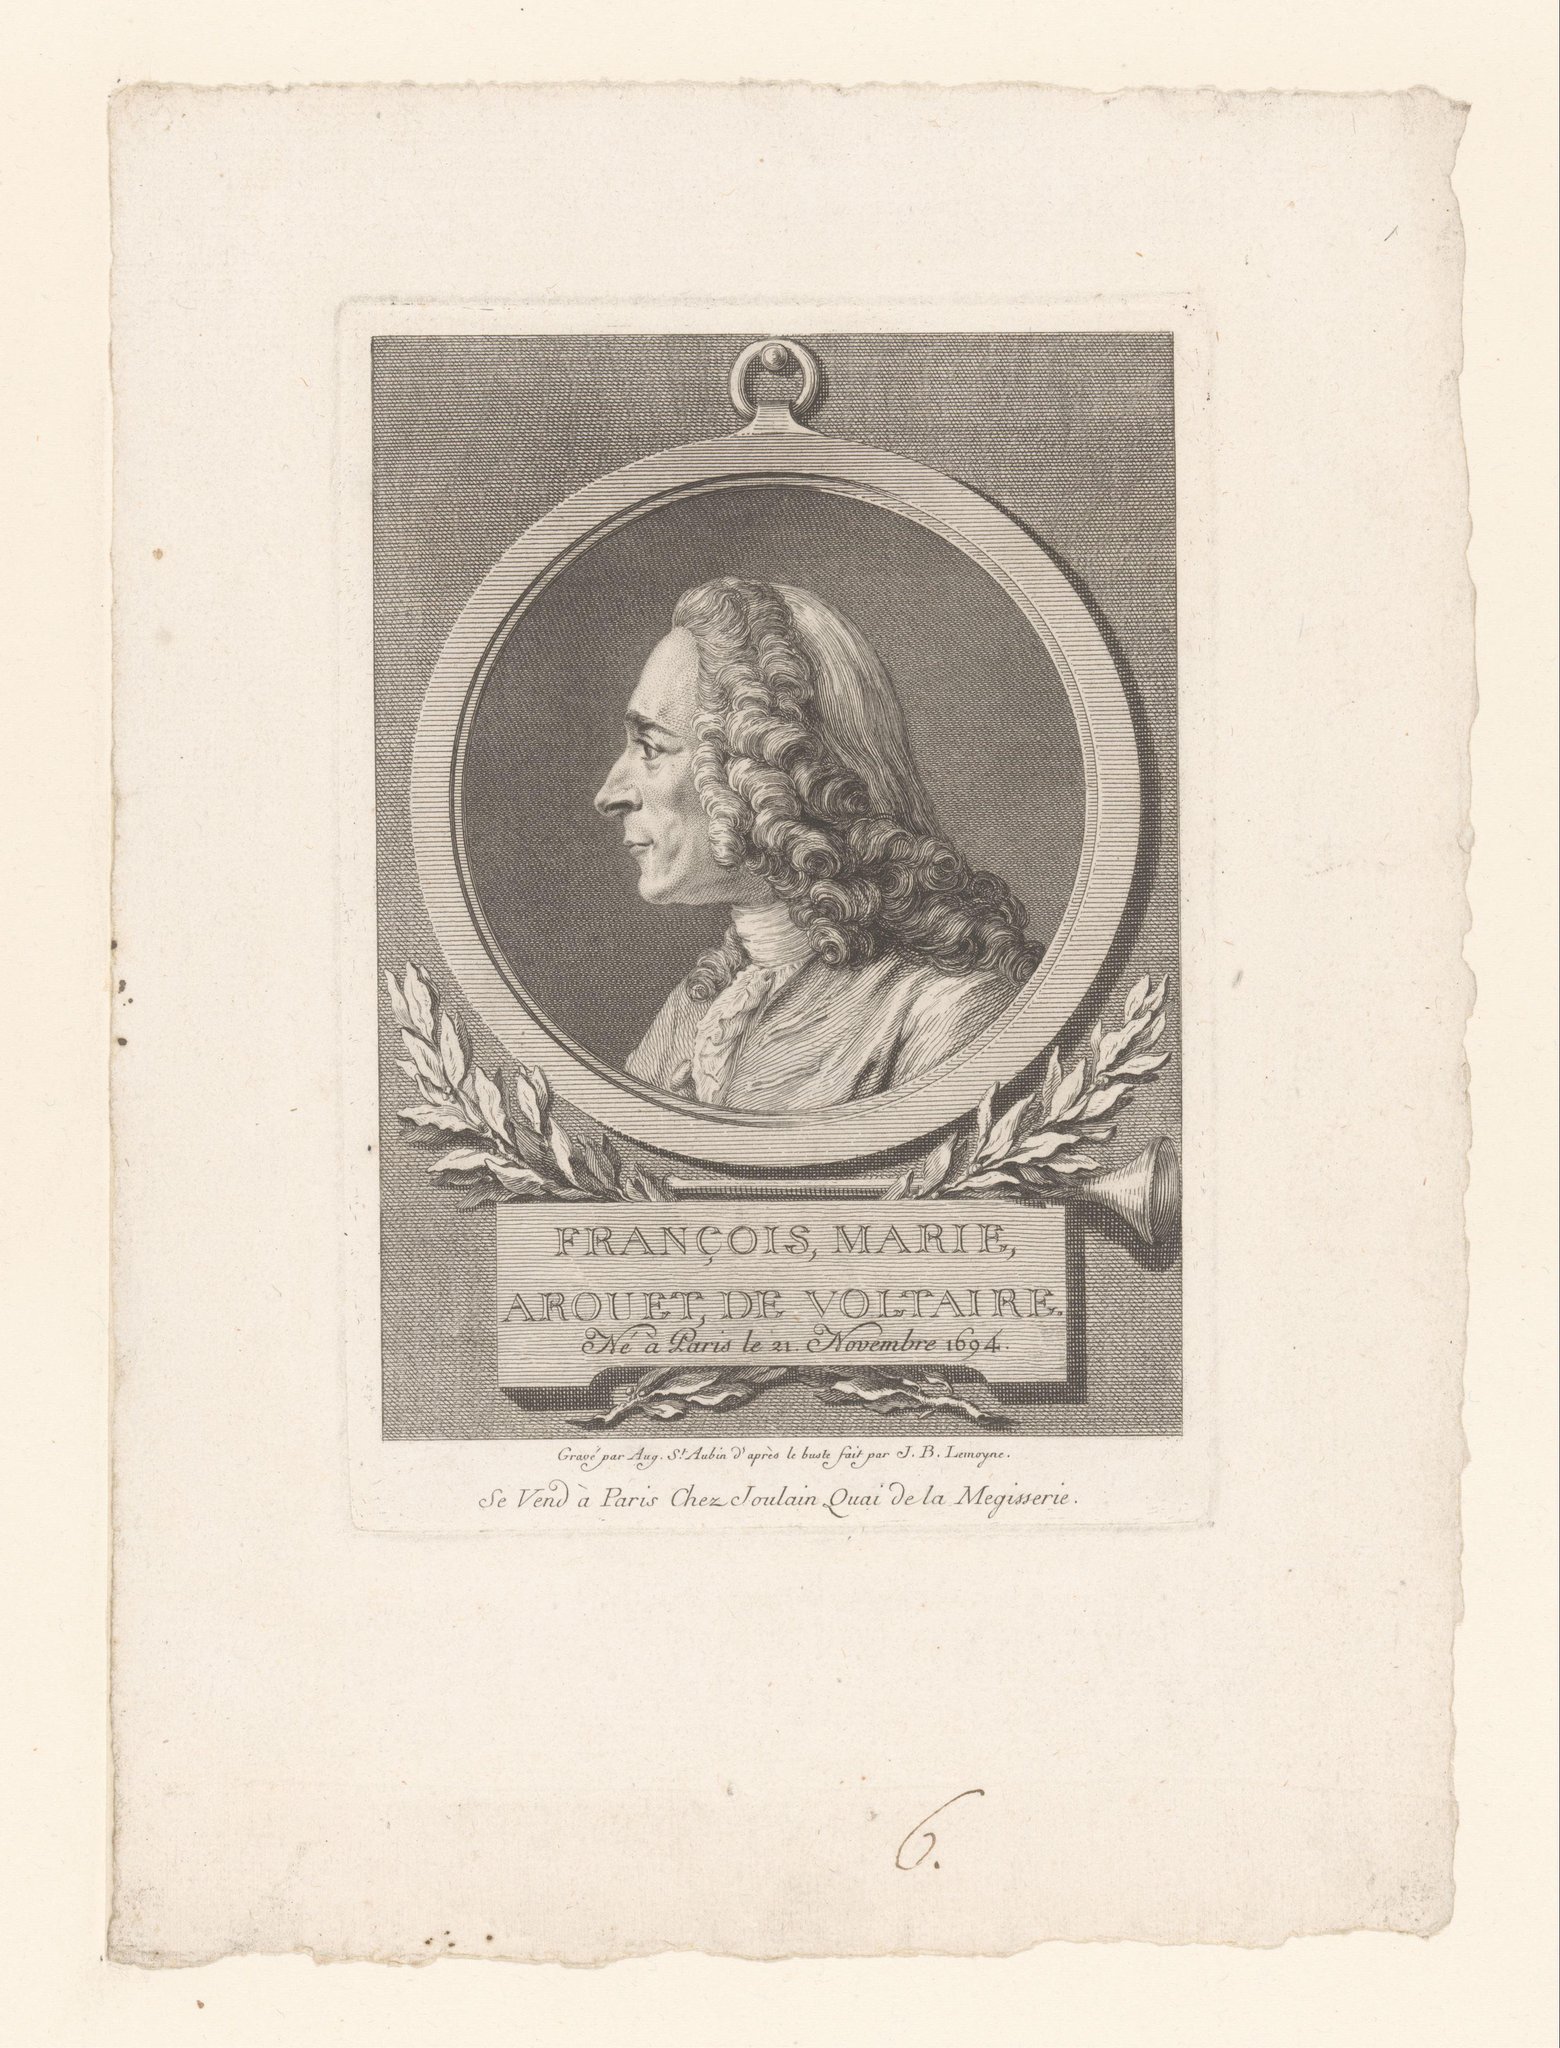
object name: print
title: Portret van Voltaire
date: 1746-1807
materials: paper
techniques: engraving, etching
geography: paris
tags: paris, voltaire, historical persons, portrait of a writer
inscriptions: collector's mark: Lugt 2228